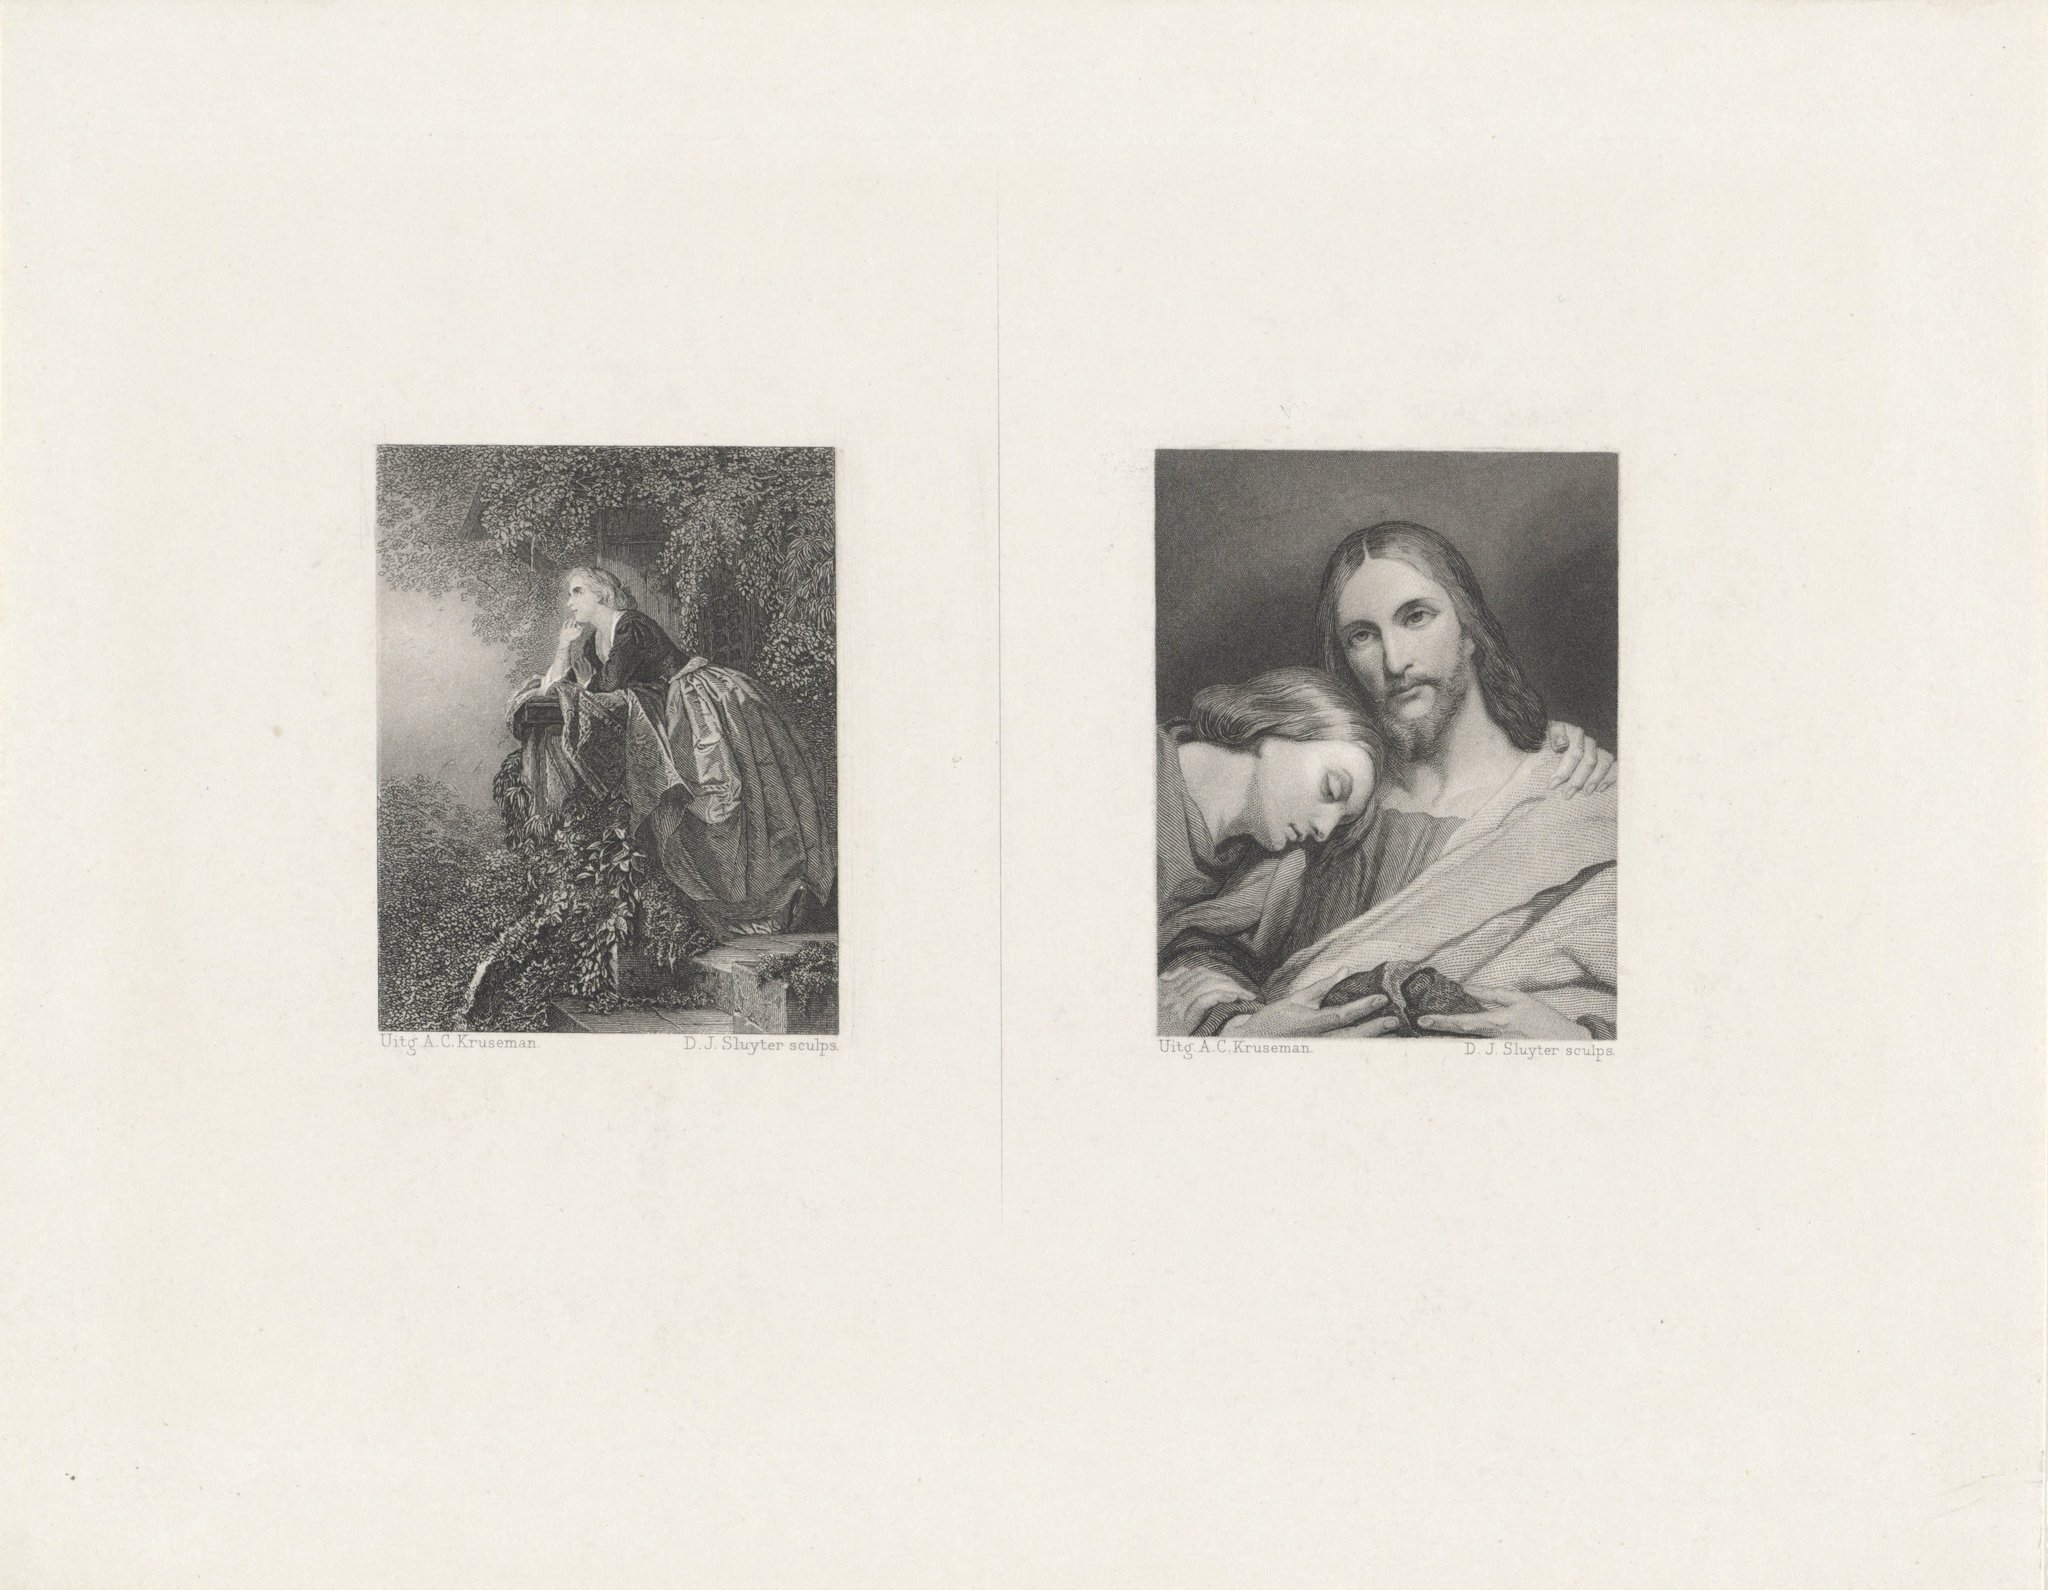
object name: book illustration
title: Jonge vrouw op haar stoep - Christus en Johannes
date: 1842-1873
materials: paper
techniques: aquatint, etching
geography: amsterdam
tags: christ with john the evangelist leaning on his breast, 'johannesminne', 'christus-johannes-gruppe', adolescent, young woman, maiden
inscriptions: collector's mark: Lugt 2228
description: Twee boekillustraties. Links een jonge vrouw in peinzende houding op haar stoepje. Rechts Christus tijdens het Laatste Avondmaal met in zijn handen het brood. Johannes de Evangelist legt zijn hoofd op zijn schouder.